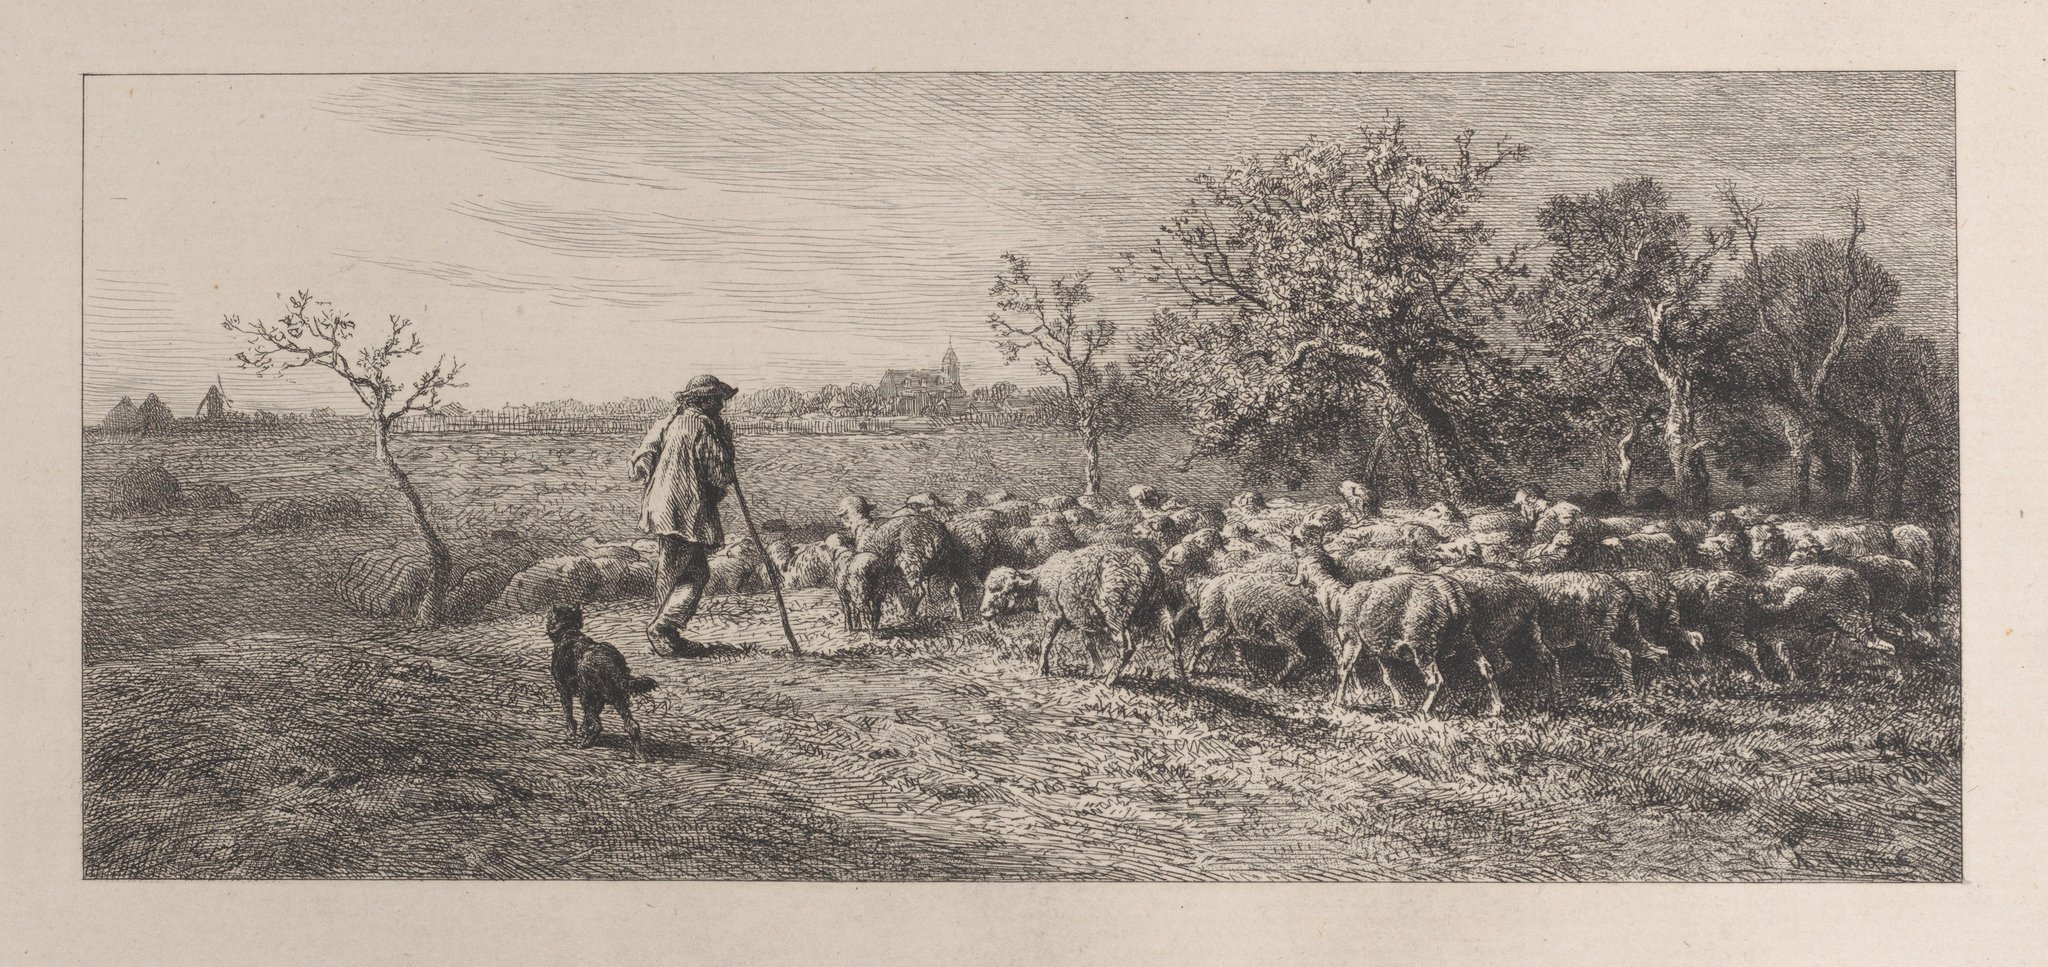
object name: print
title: Arrival in the Field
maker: charles émile jacque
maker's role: artist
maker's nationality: french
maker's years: 1813-1894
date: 1864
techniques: etching